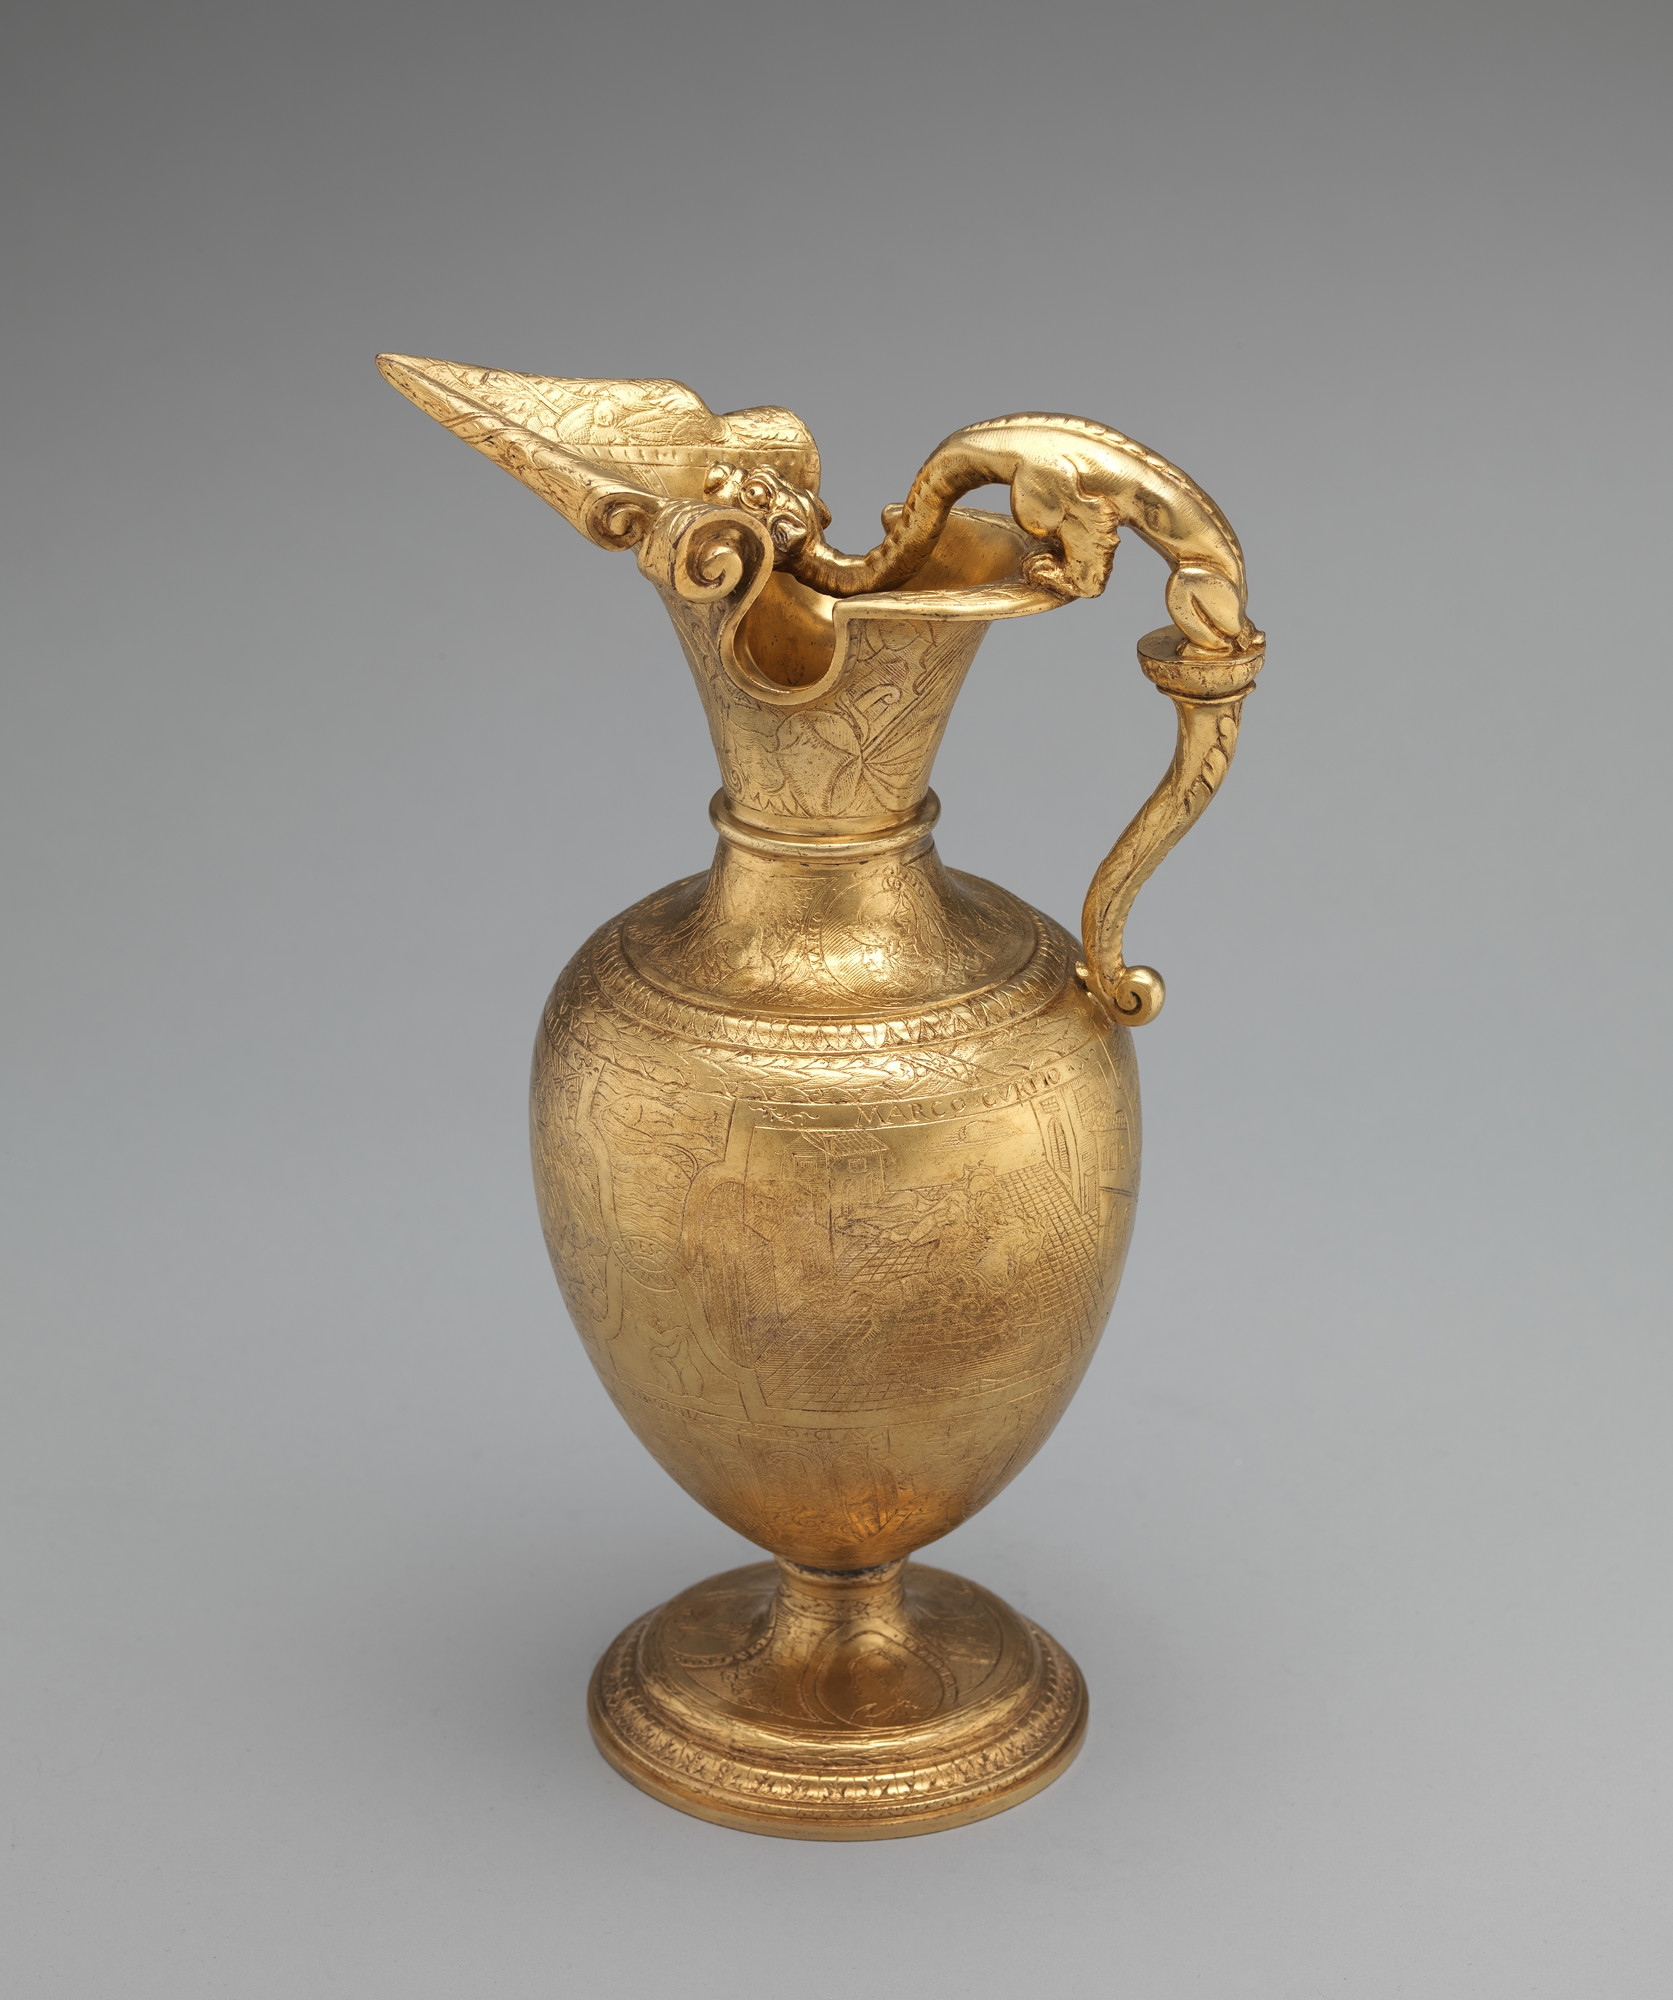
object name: ewer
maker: franchi and son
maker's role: manufacturer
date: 1801-1900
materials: bronze